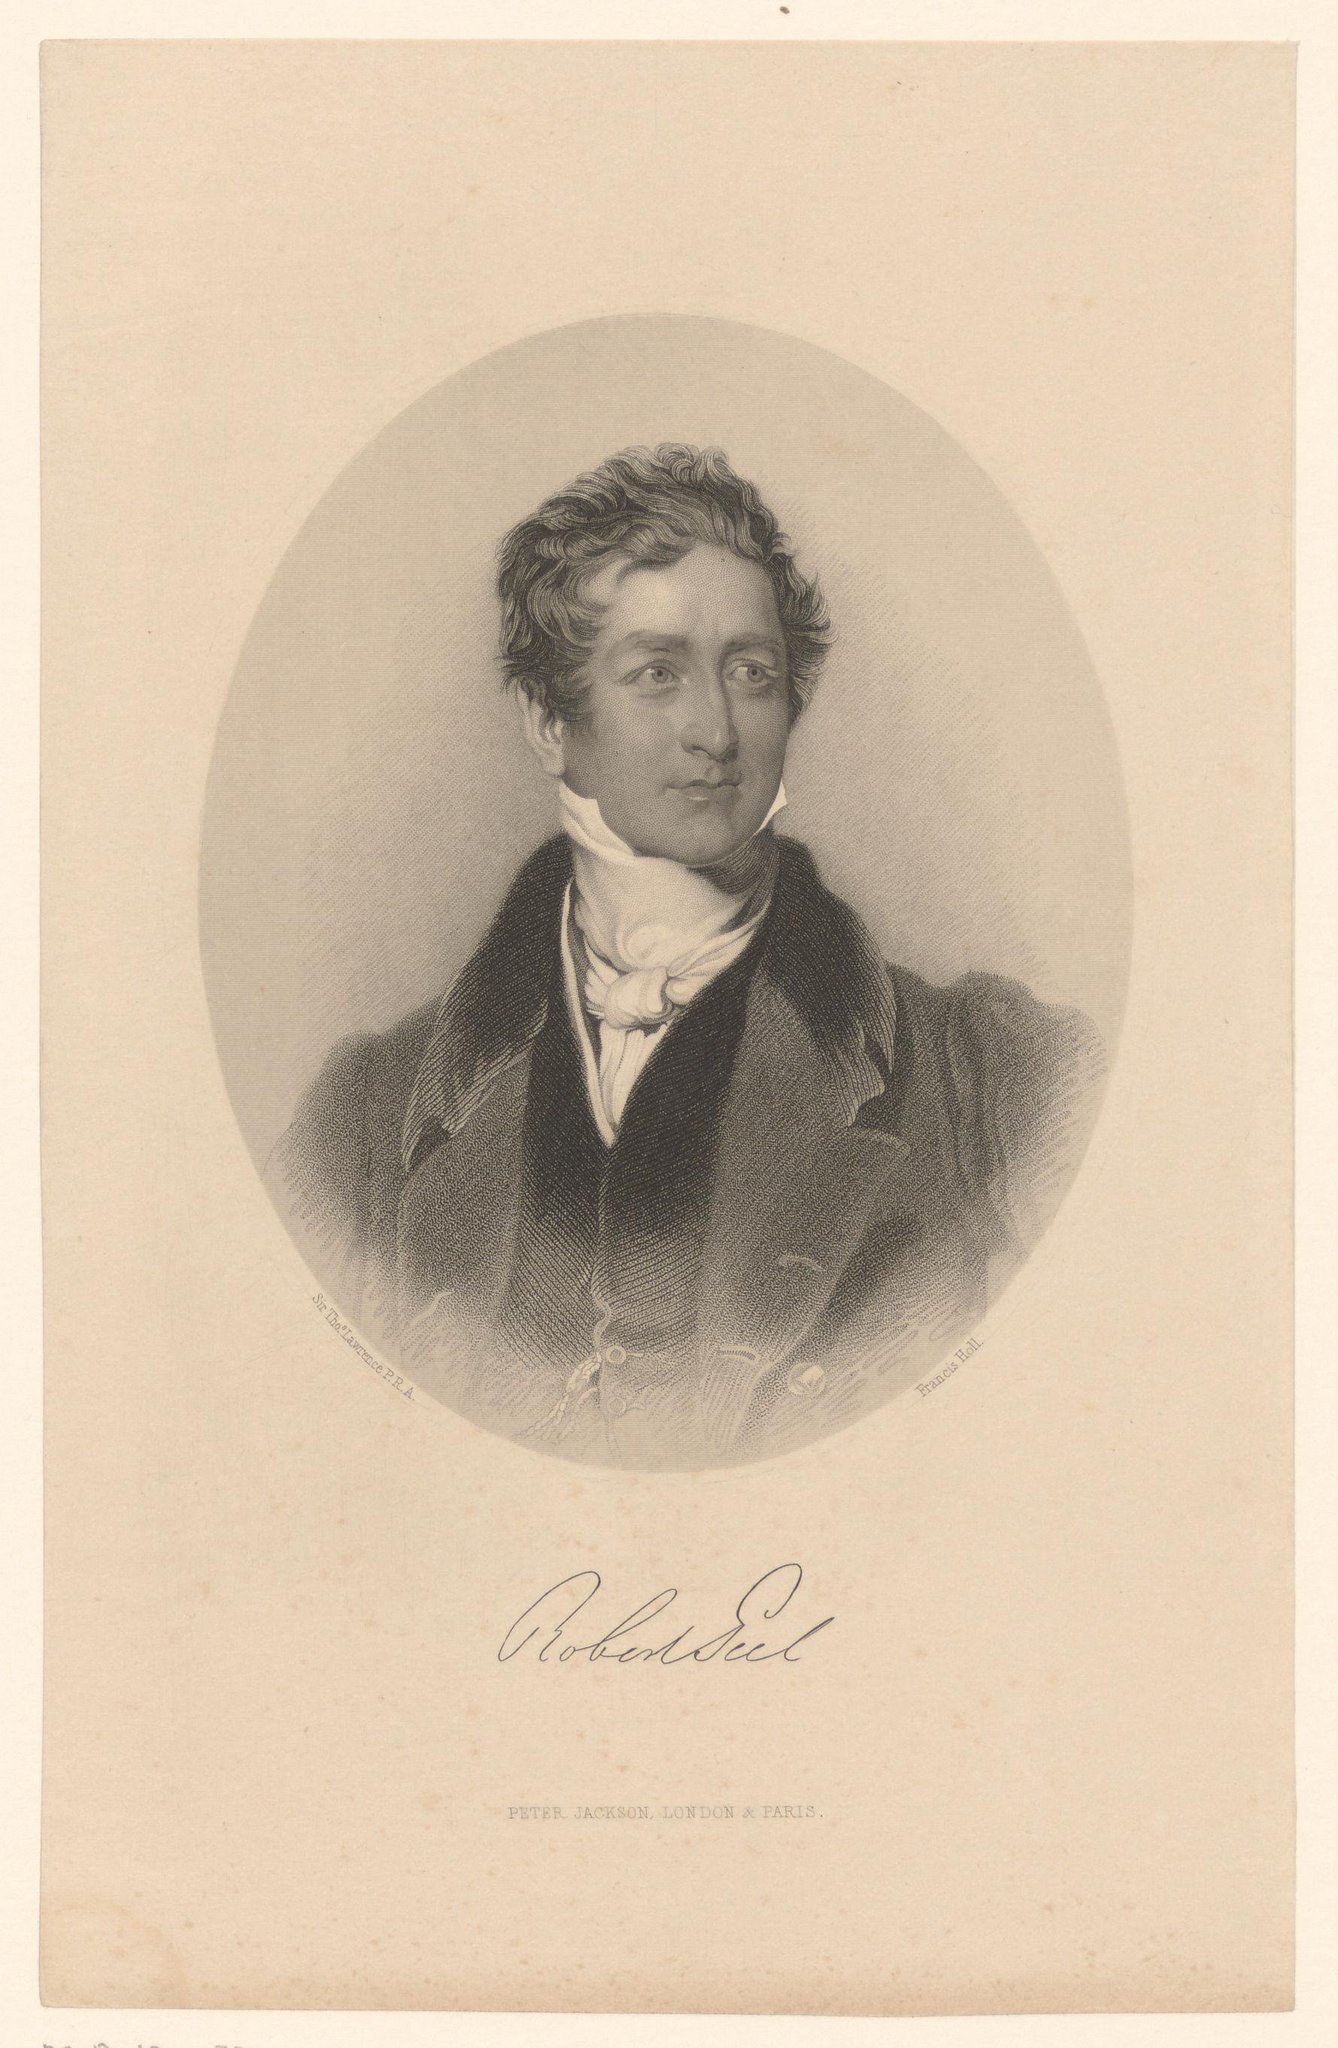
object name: print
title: Portret van Robert Peel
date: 1825-1884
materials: paper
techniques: engraving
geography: paris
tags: london, historical persons, politician, e.g. party leader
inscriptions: collector's mark: Lugt 2228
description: Een facsimile signatuur in de ondermarge.